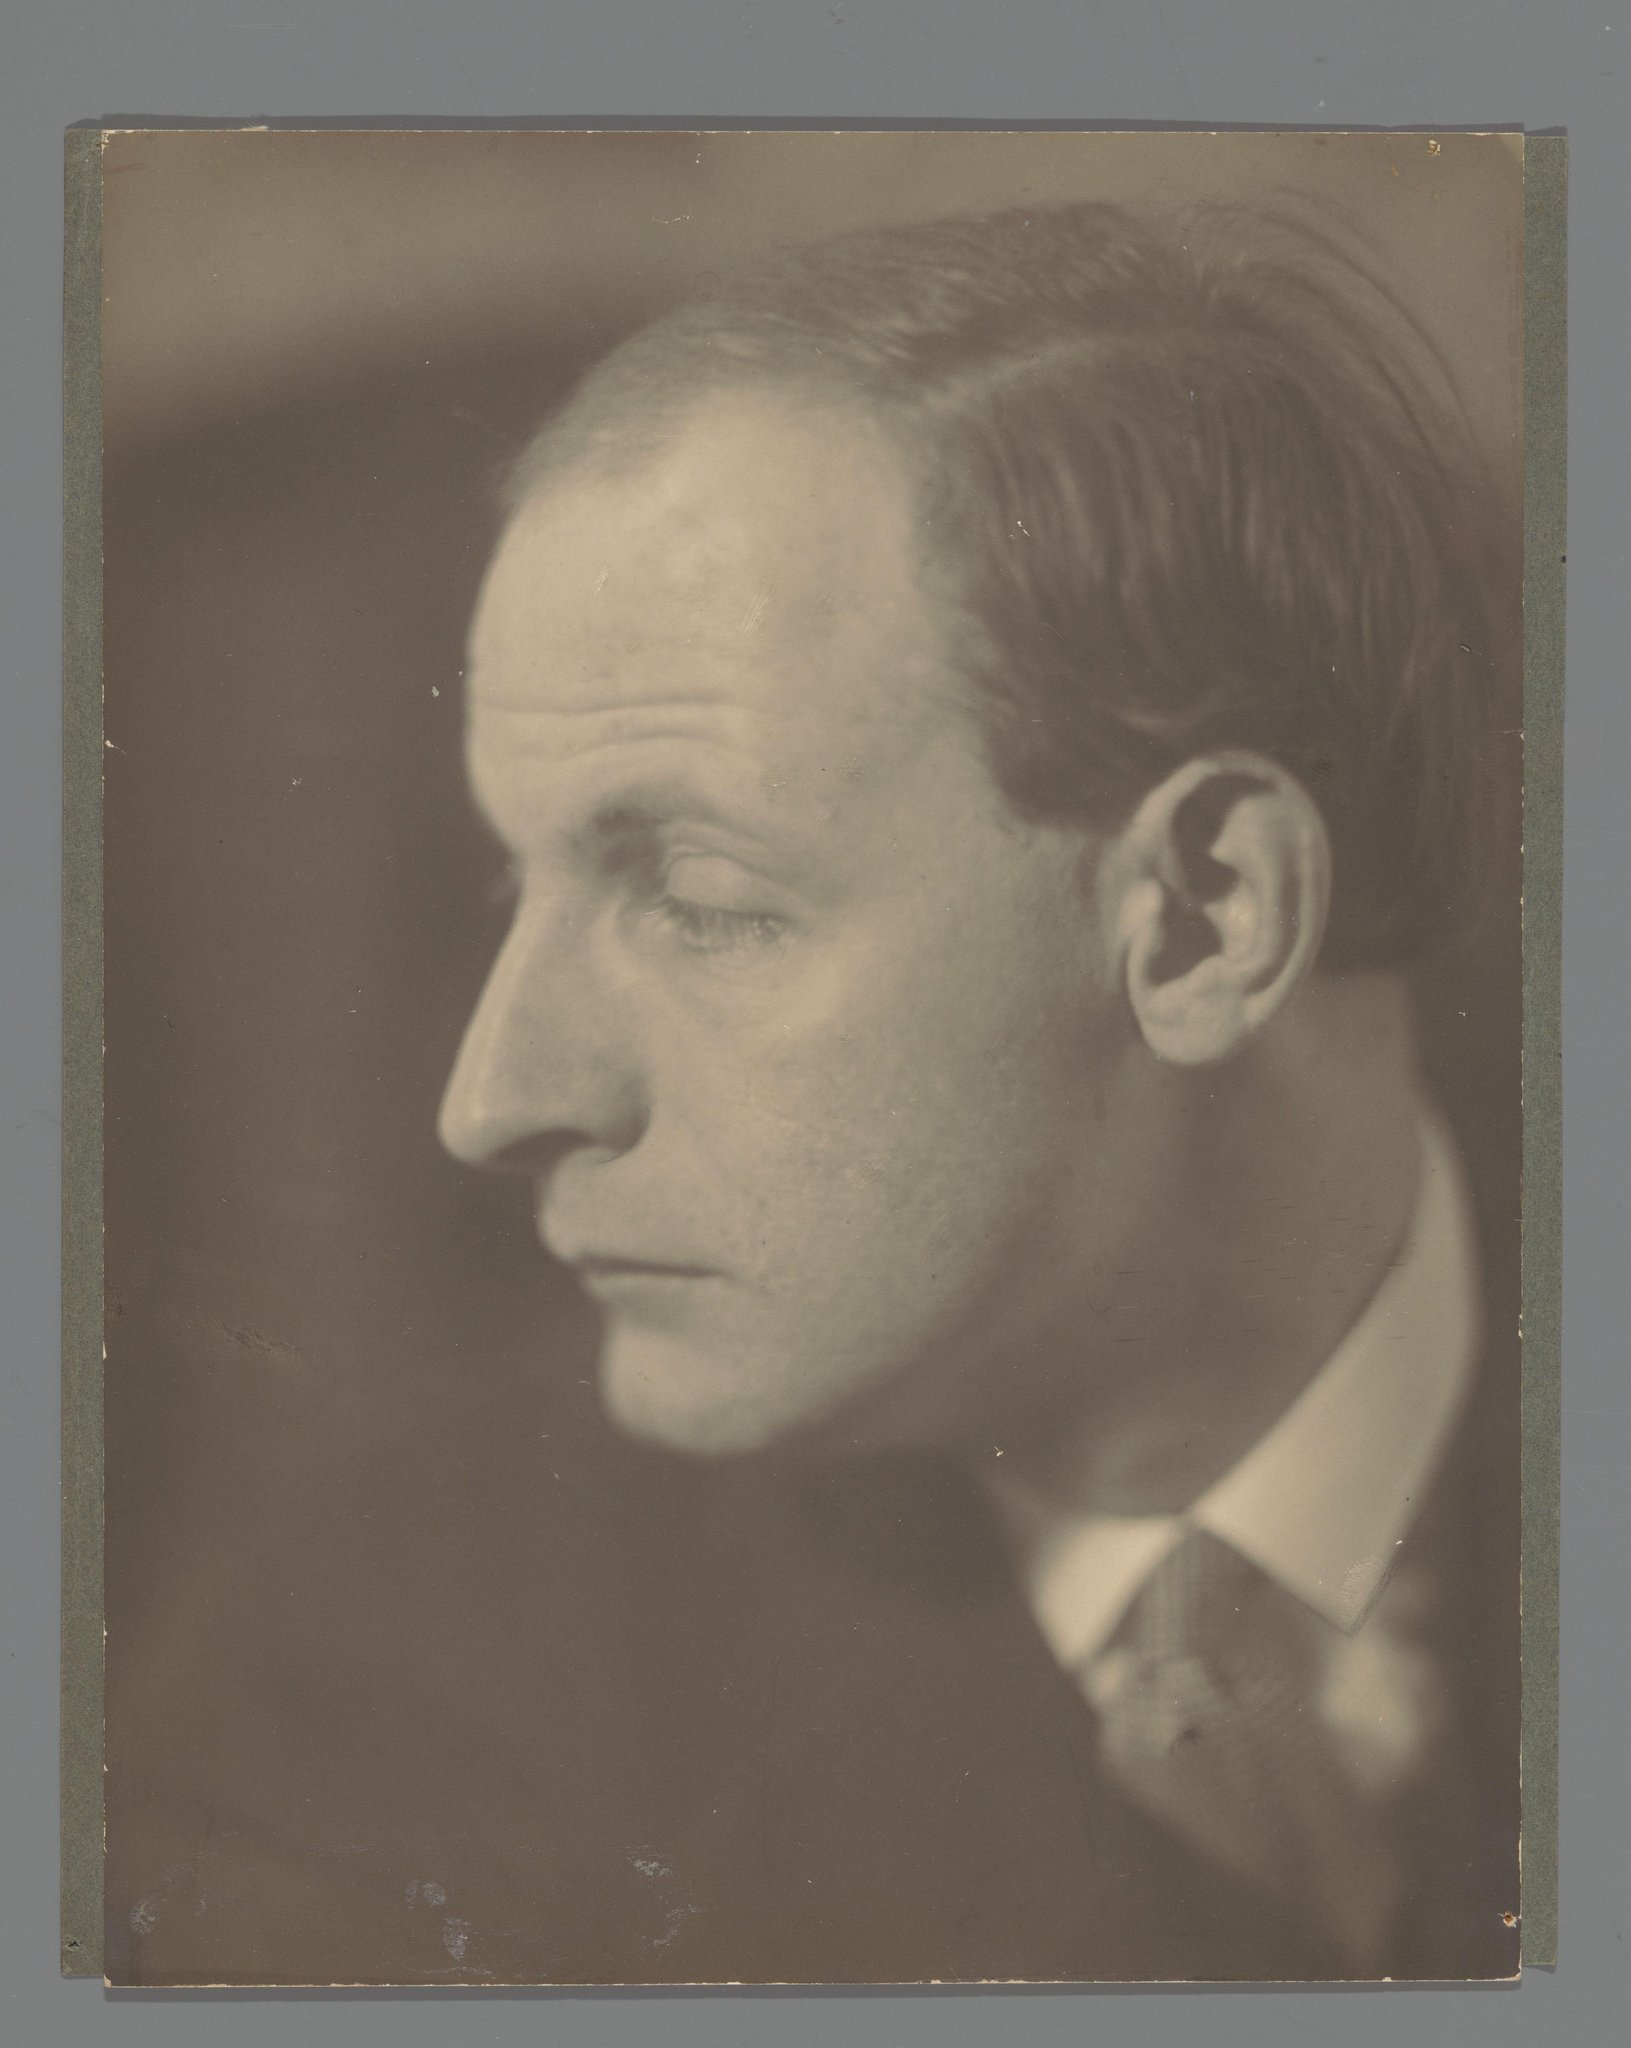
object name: photograph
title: Portret van een man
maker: Anonymous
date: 1900-1985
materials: cardboard, photographic support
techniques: gelatin silver print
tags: historical persons not known by name